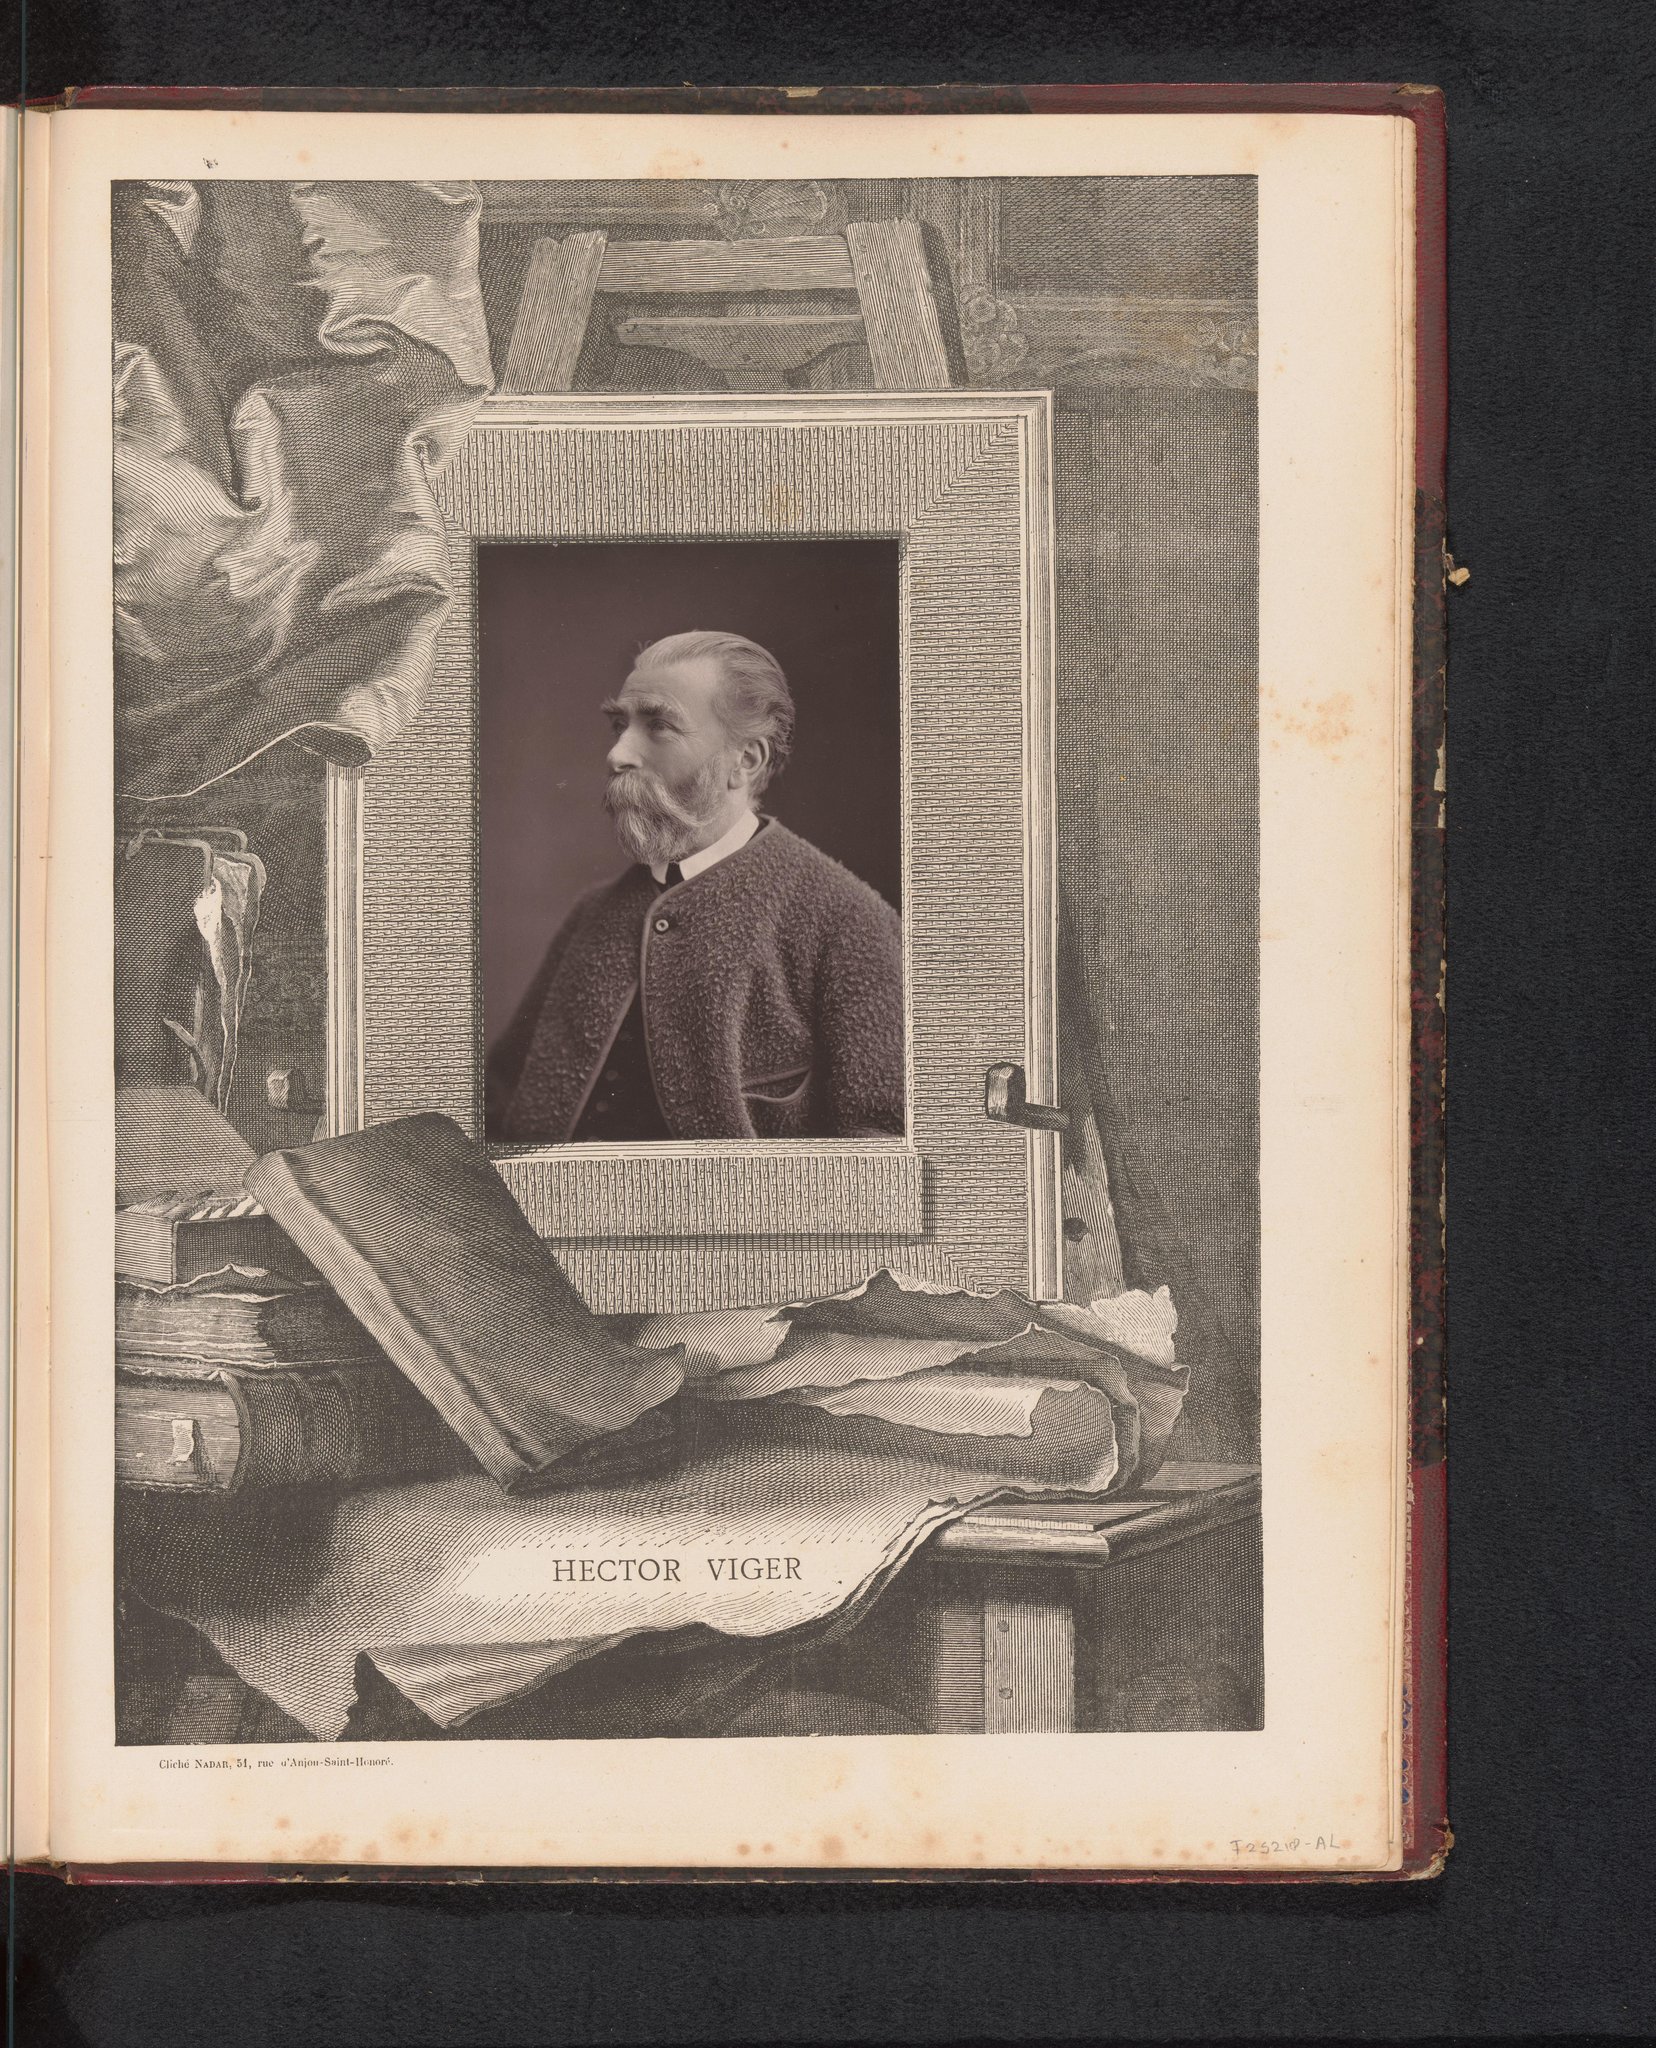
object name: page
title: Hector Viger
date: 1872-1877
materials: paper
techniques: woodburytype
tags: hector viger, adult man, historical persons